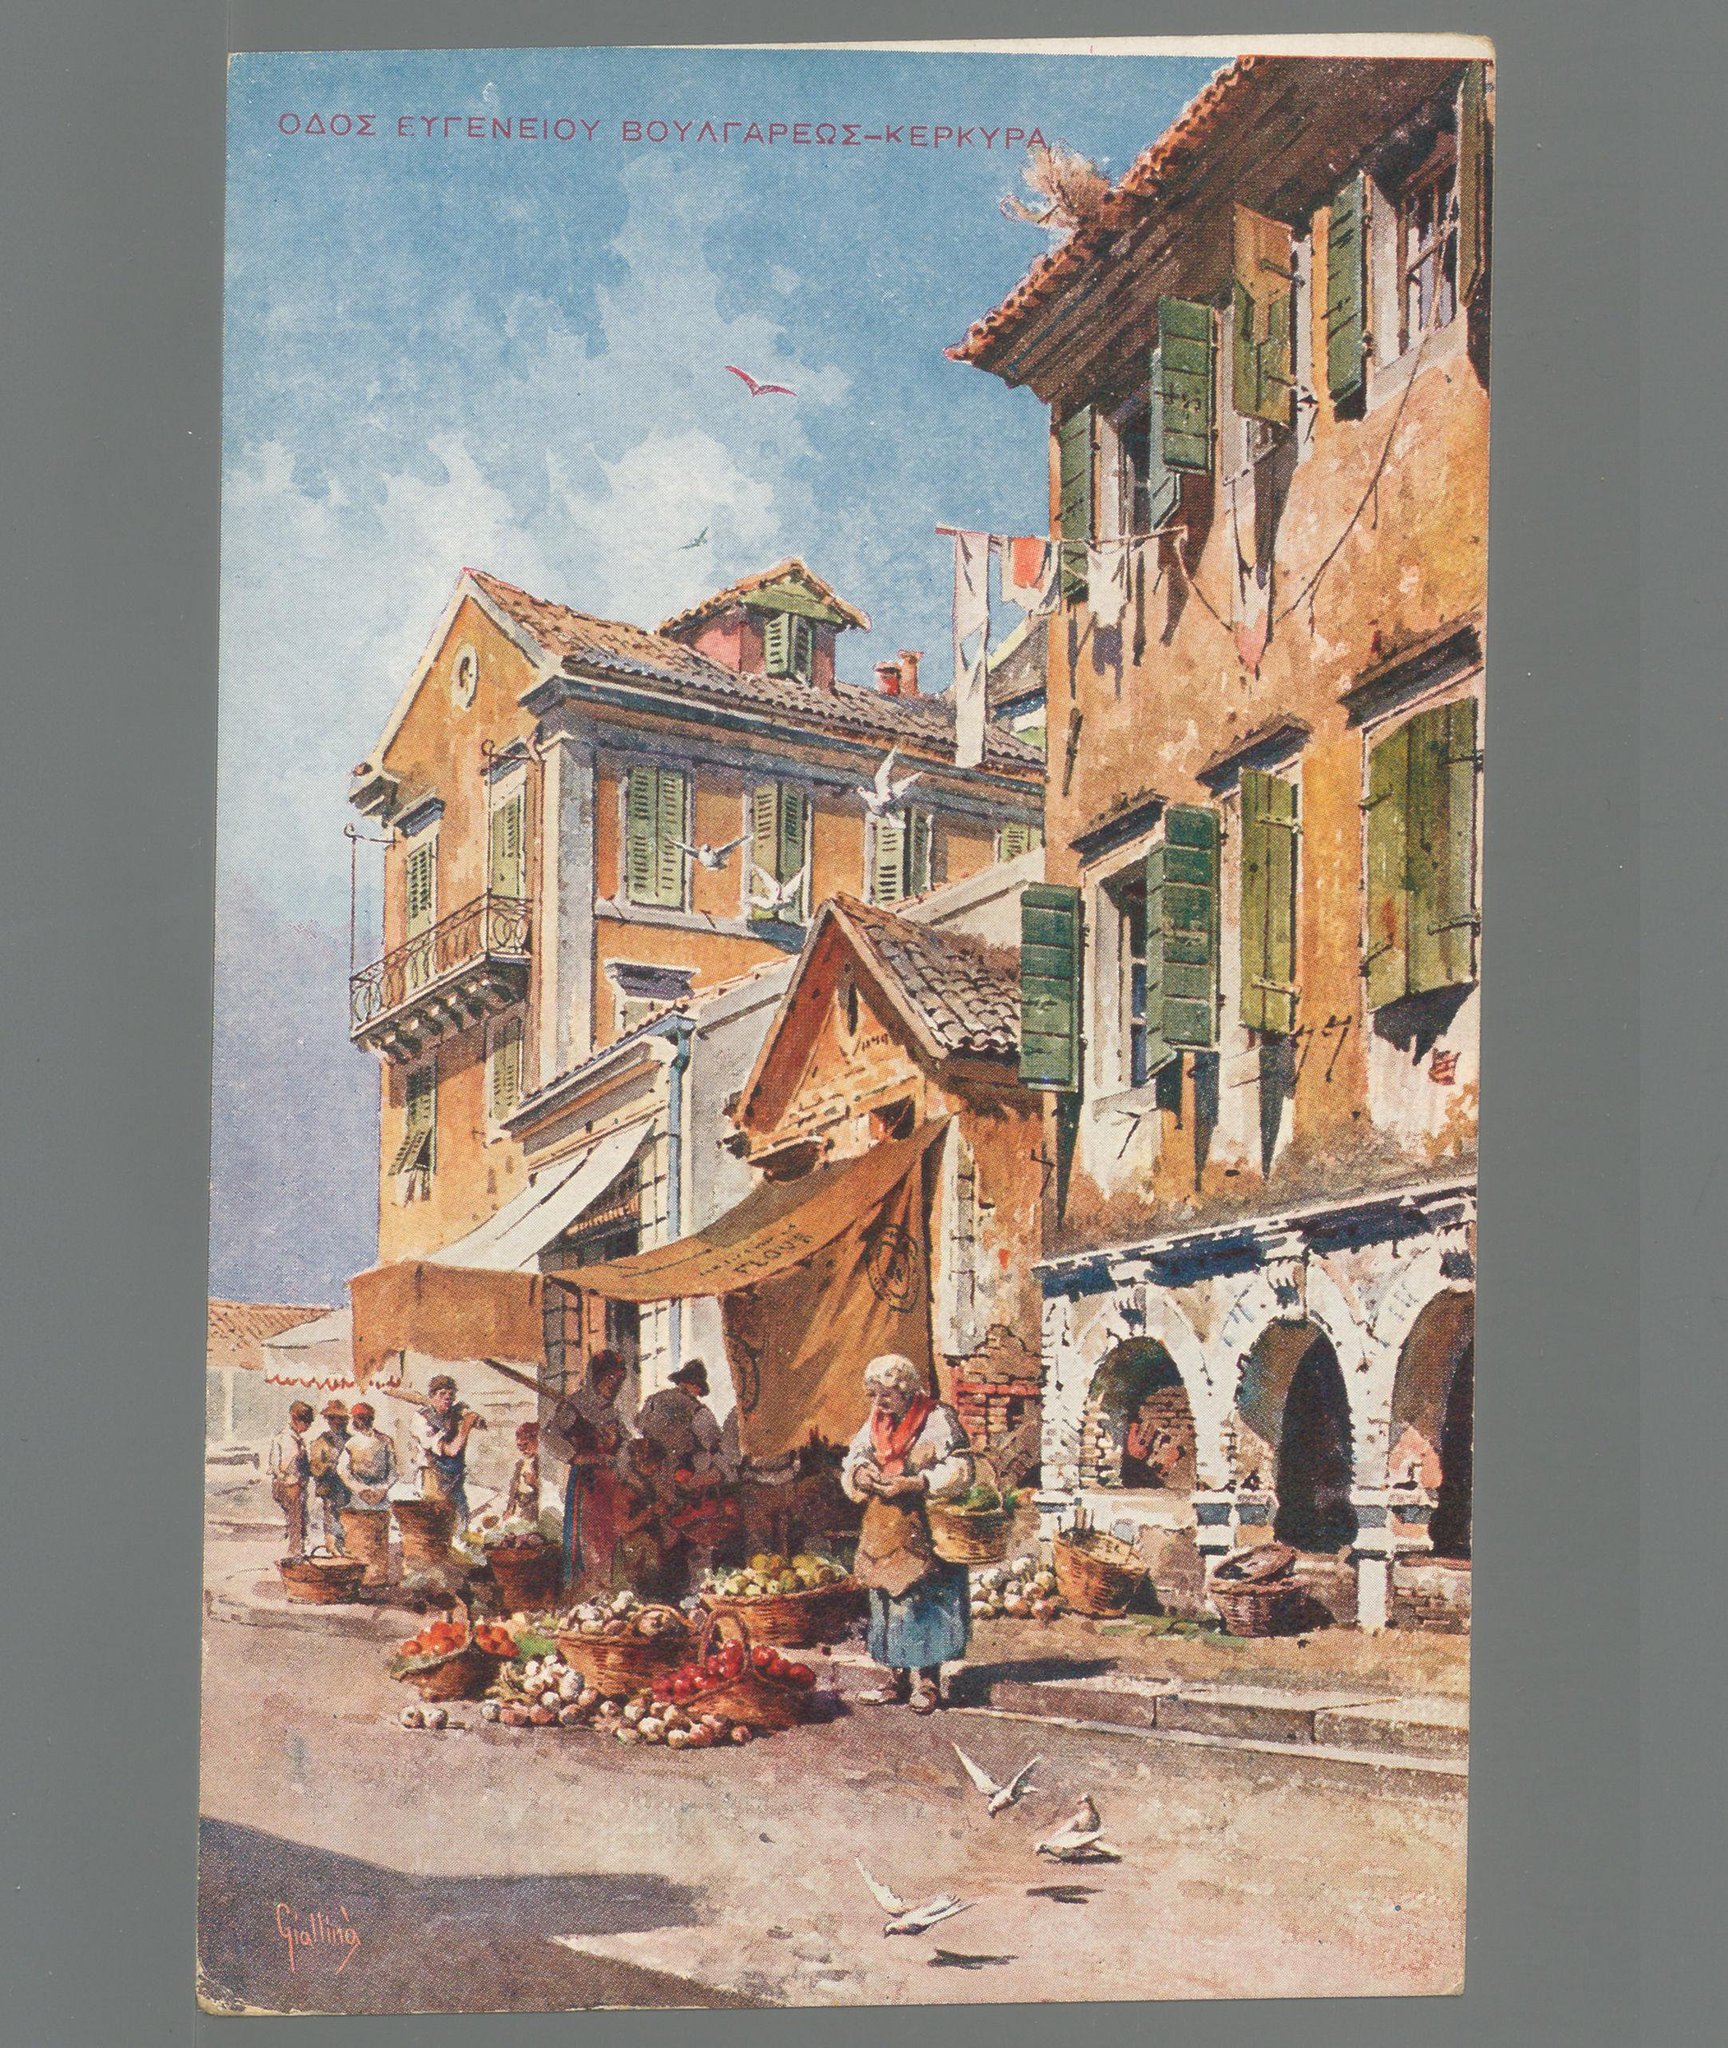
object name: reproduction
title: Gezicht op een straat met winkels te Korfoe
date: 1906-1909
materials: cardboard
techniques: writing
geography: corfu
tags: shop, store, street